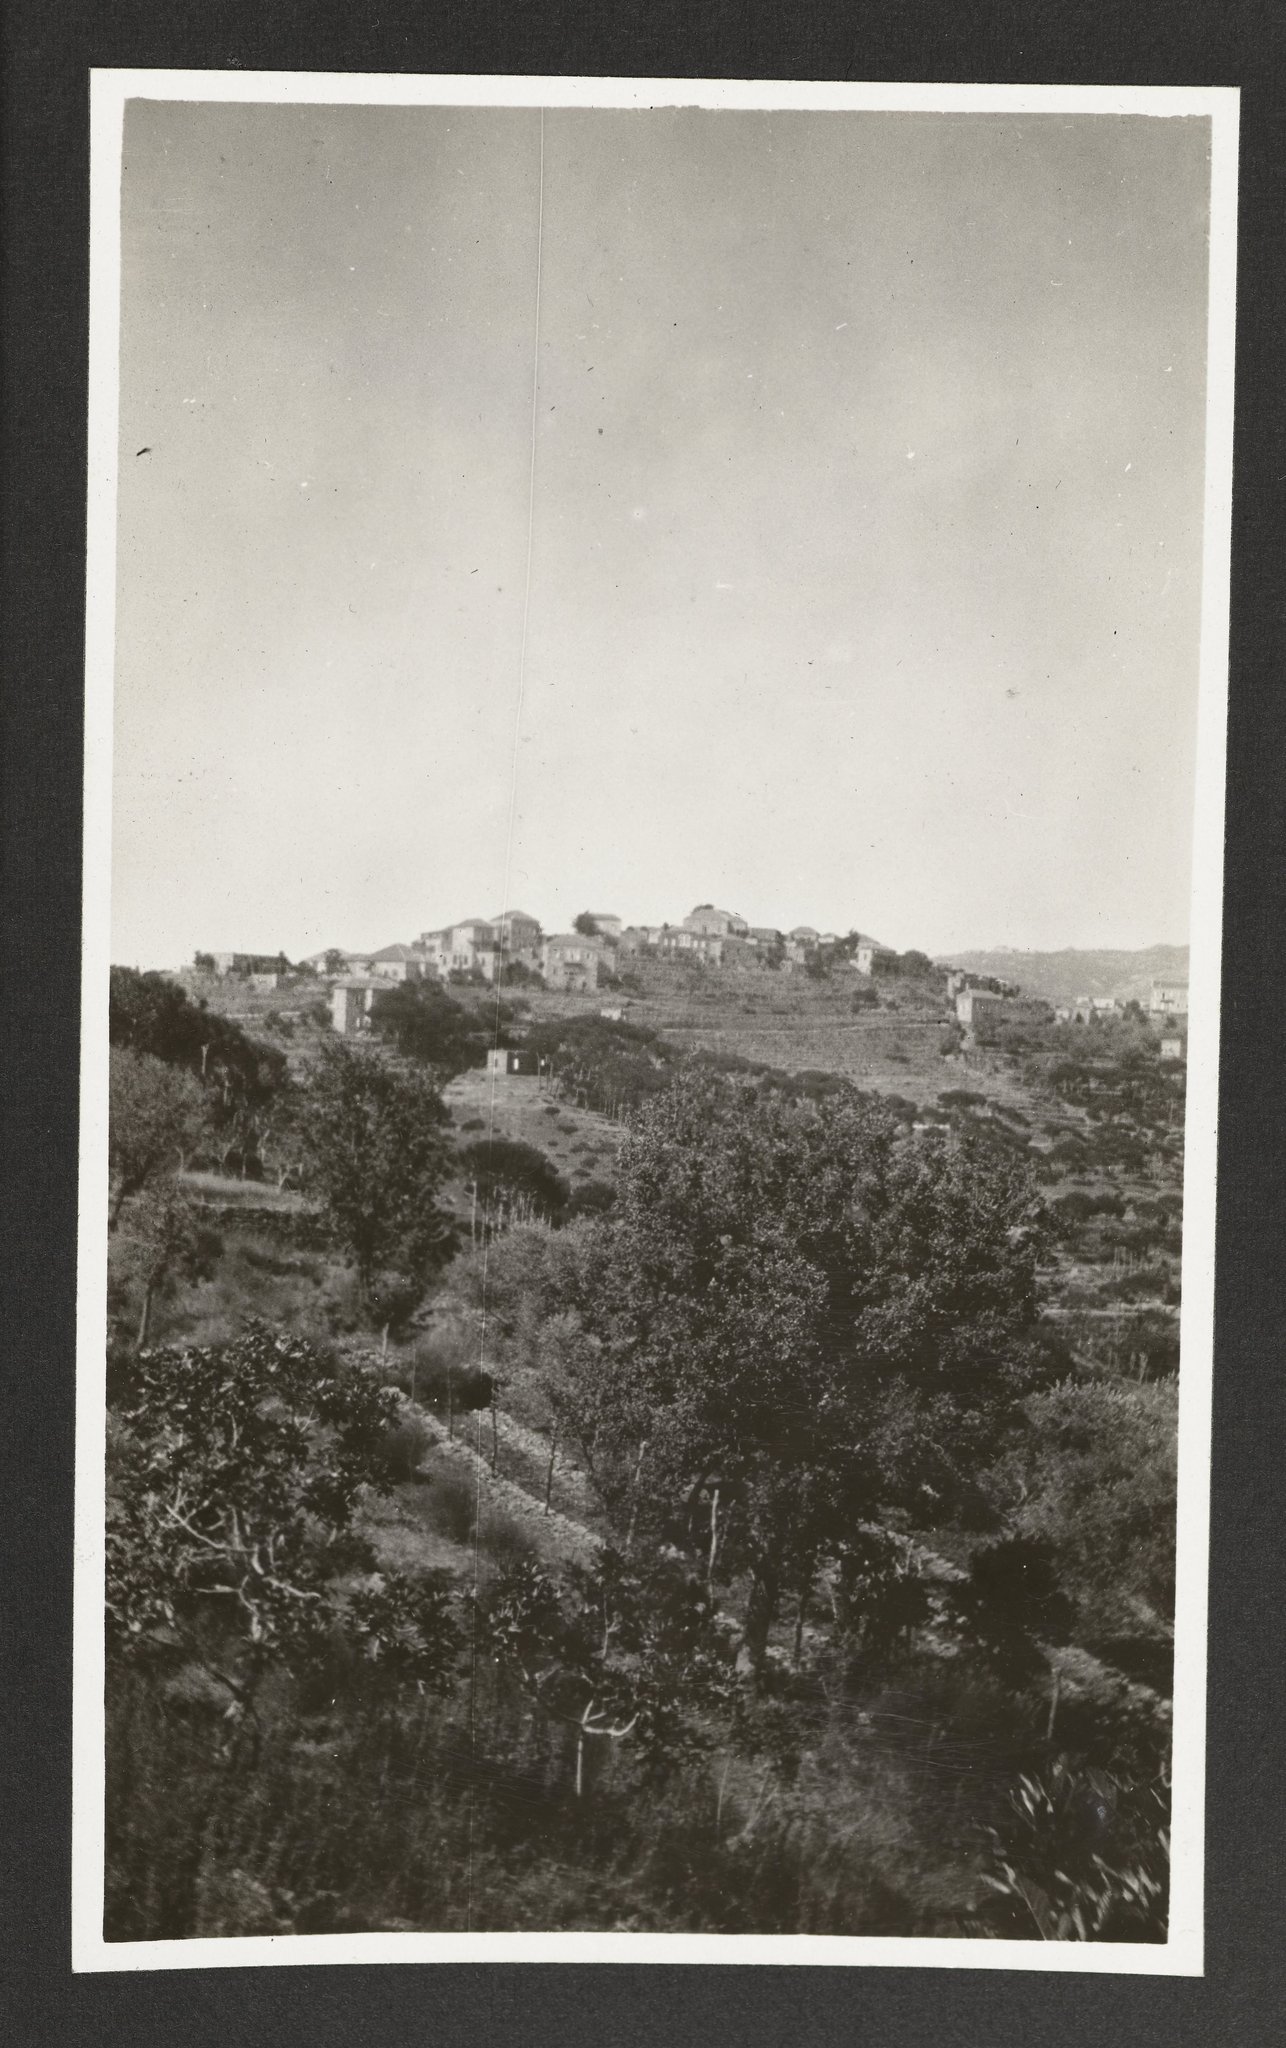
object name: photograph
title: Gezicht op het Libanon gebergte bij Broumana, Syrië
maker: a.g.a. van eelde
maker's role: engineer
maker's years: 1862-1950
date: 1925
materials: cardboard, paper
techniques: gelatin silver print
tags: libanon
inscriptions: number: ‘41.’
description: Titel op object afkomstig uit inventaris (Verklaring der Photo's) behorend bij het album.